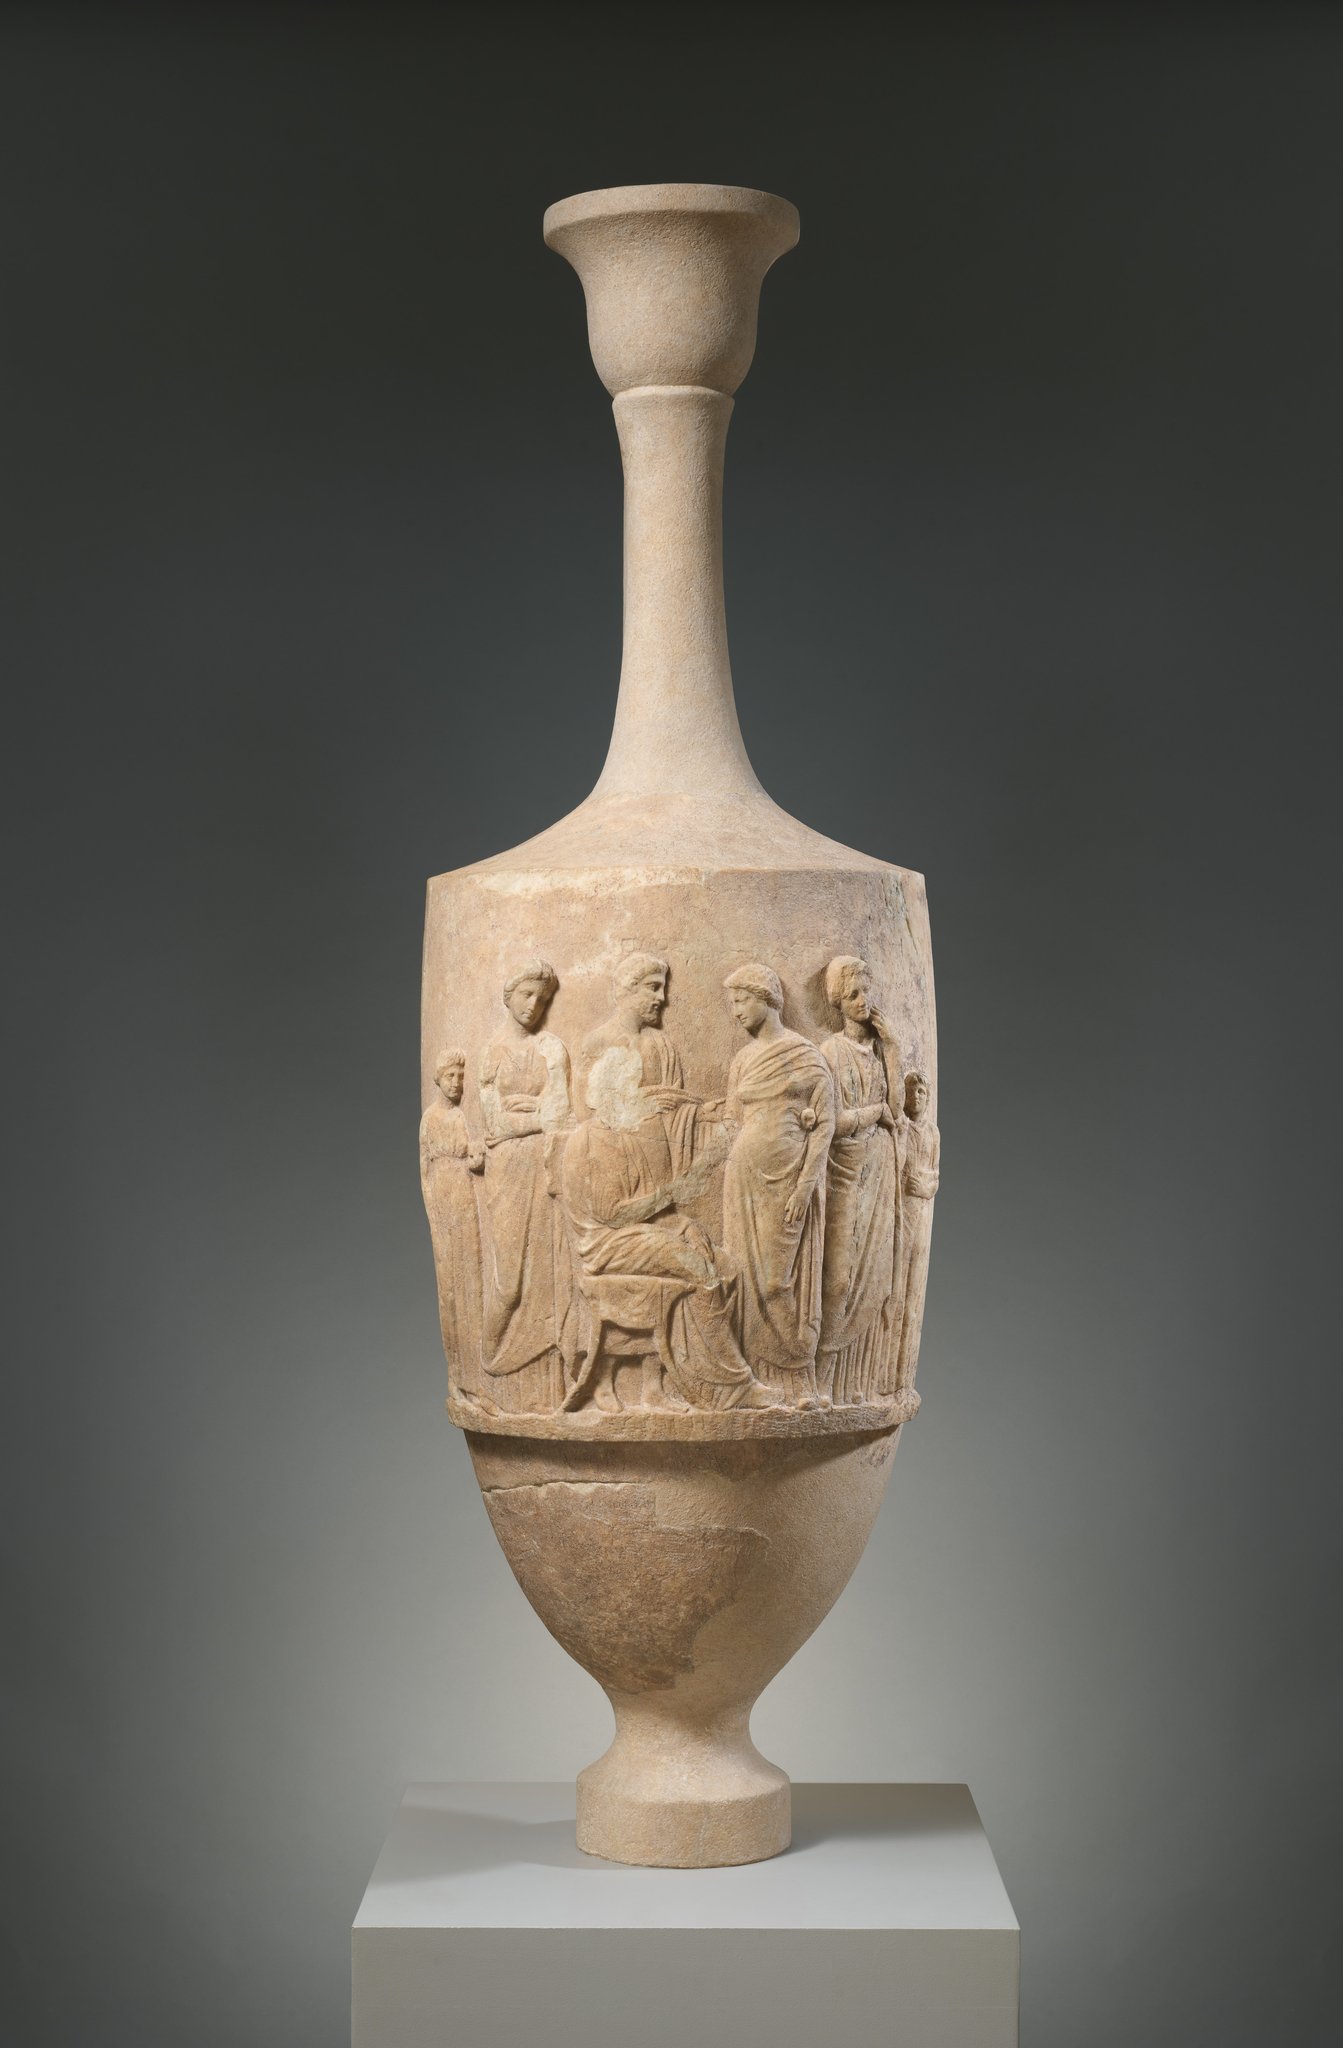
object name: lekythos, funerary, of aristomache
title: Marble funerary lekythos of Aristomache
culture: greek, attic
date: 375-350 BCE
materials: marble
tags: men,women,servants